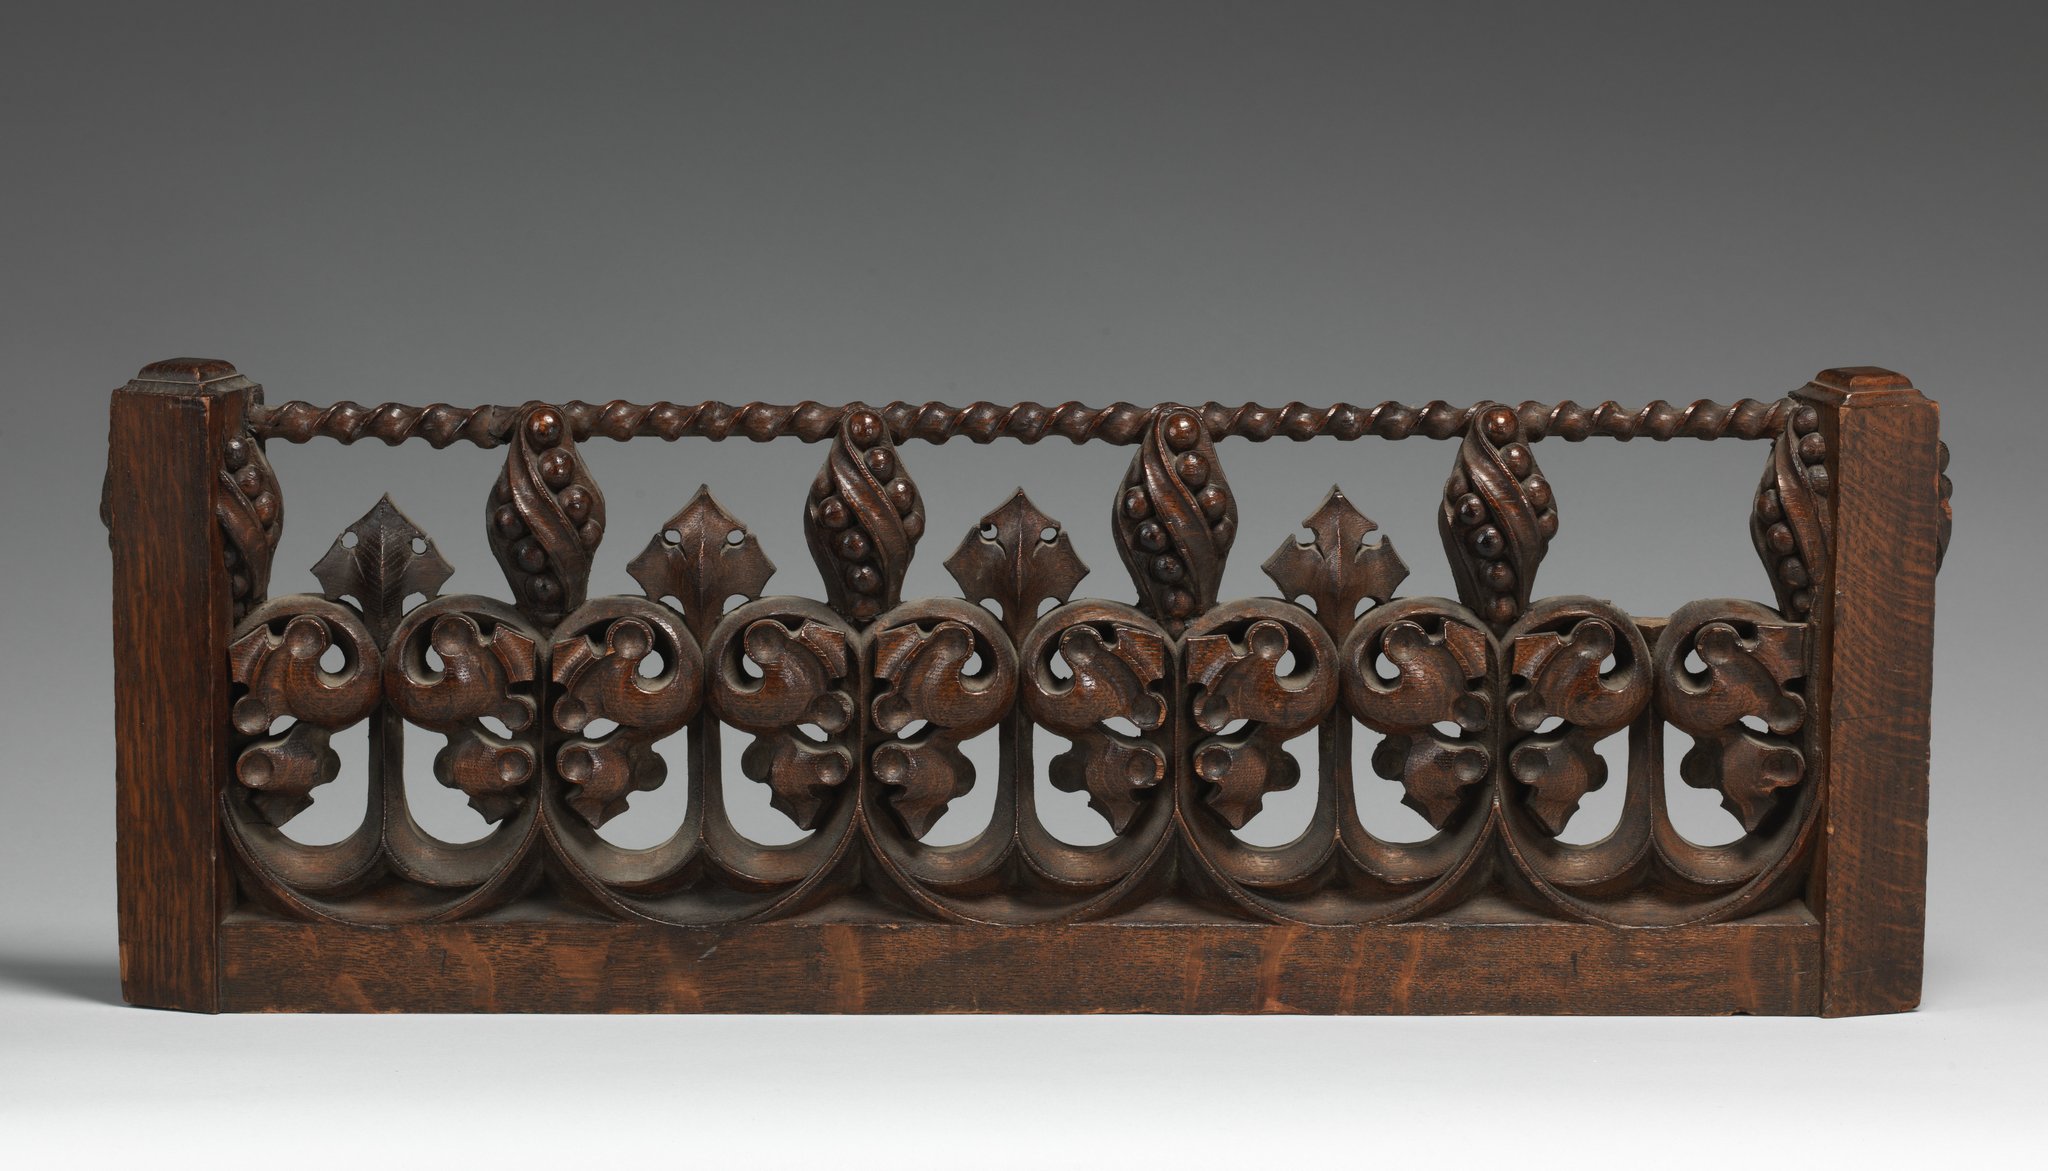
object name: panel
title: Panel from the Palace of Westminster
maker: augustus welby northmore pugin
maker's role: designer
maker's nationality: british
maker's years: 1812-1852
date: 1847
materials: wood